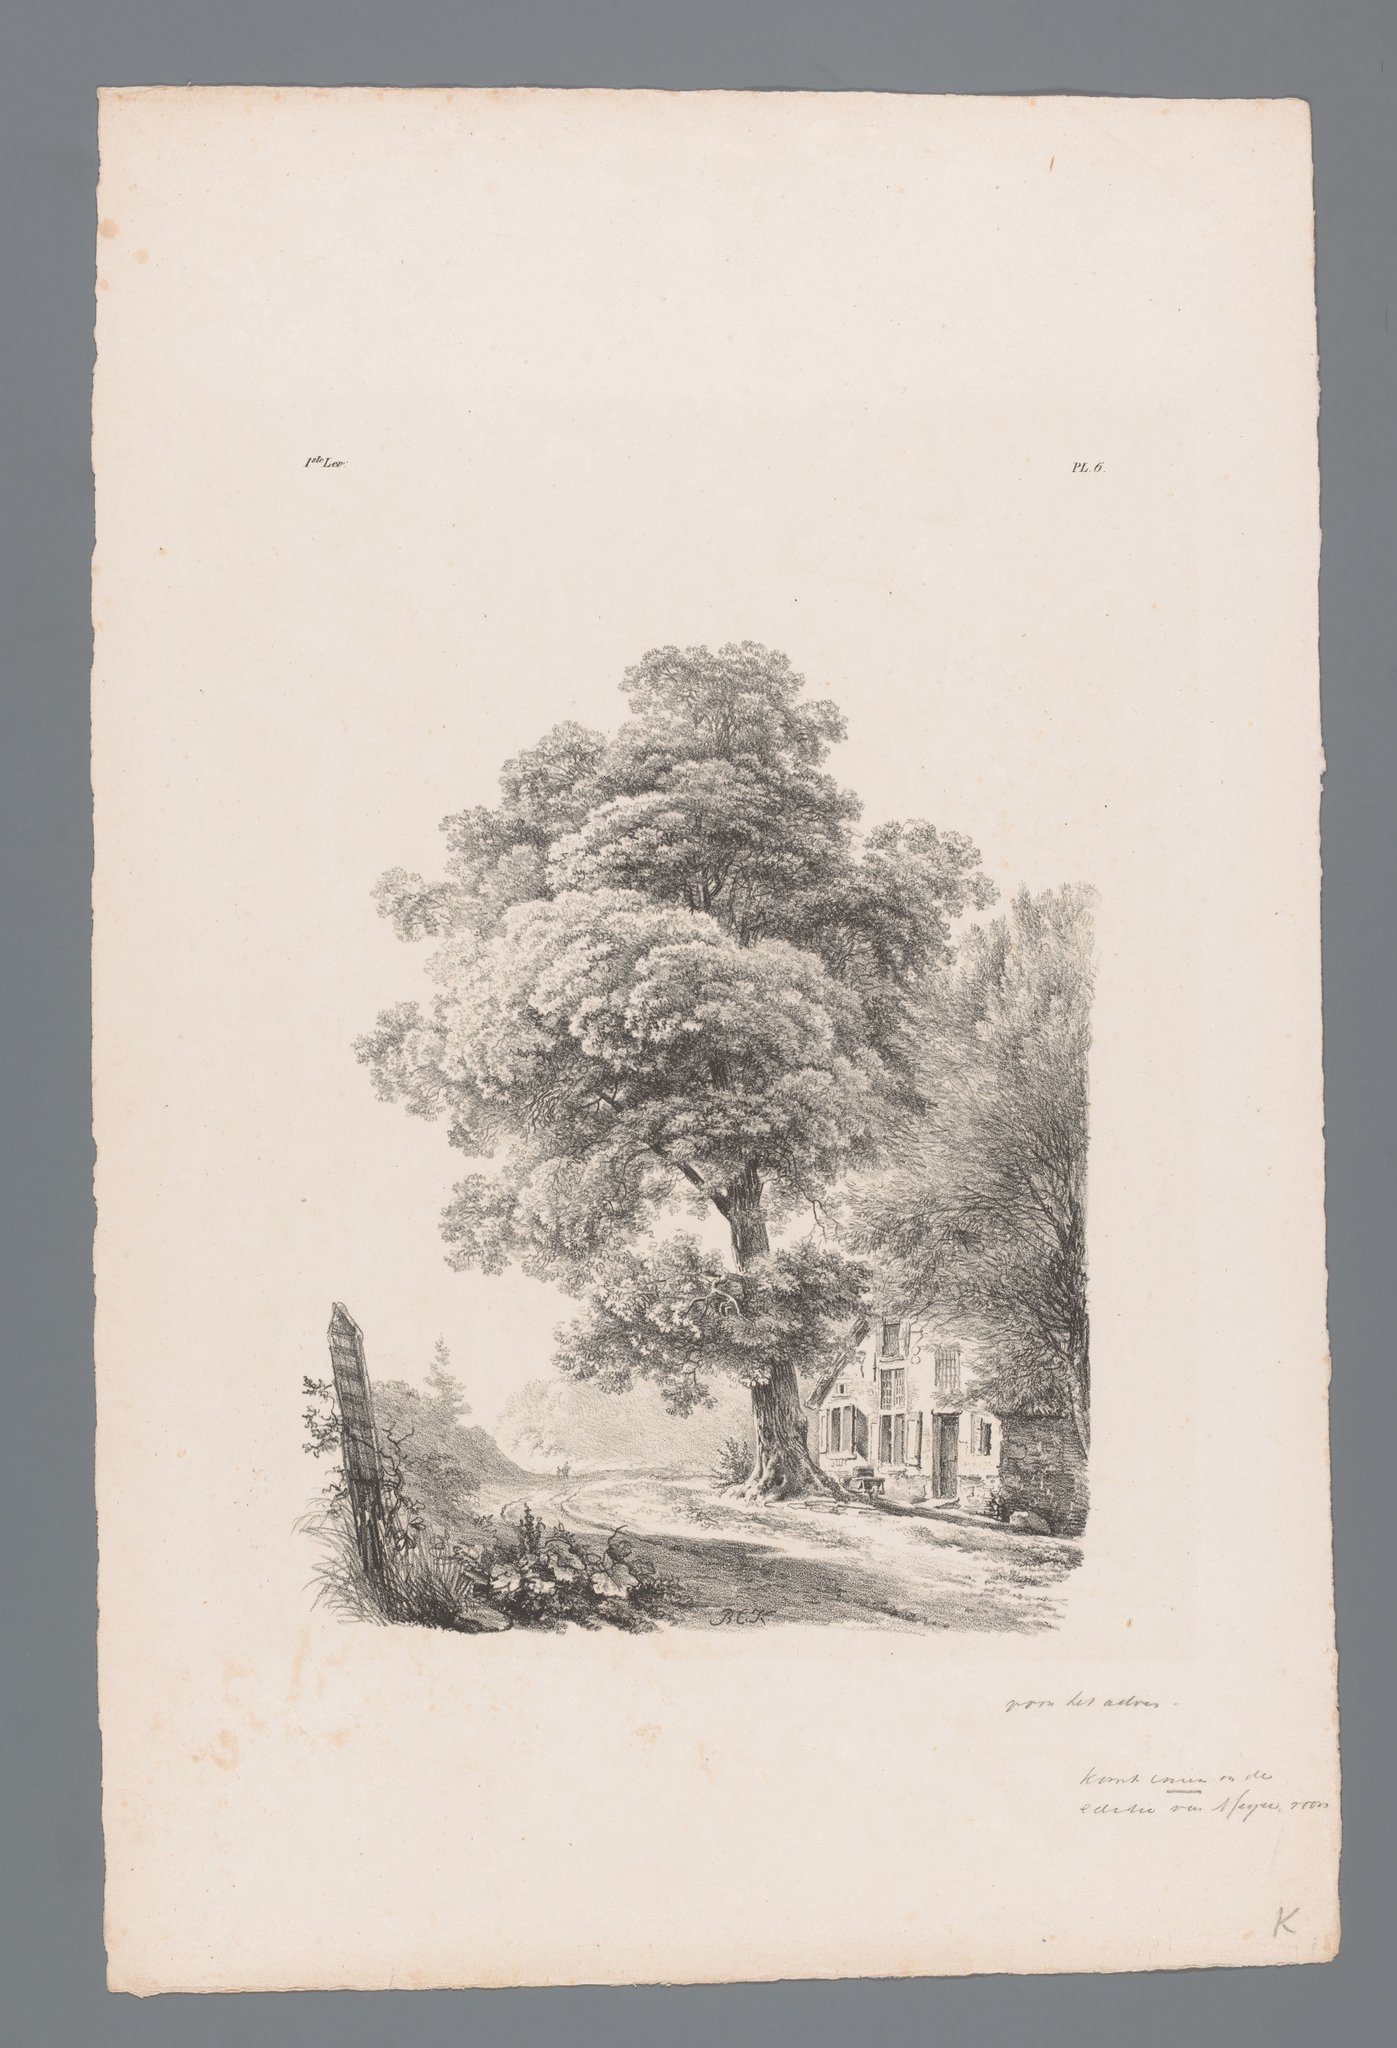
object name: print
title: Landschap studiën eerste levering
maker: barend cornelis koekkoek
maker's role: draughtsman, painter, print maker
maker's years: 1803-1862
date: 1829-1844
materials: paper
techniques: lithograph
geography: amsterdam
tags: trees, road, path, farm (building)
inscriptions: inscription: ‘Voor het adres / komt niet in de / editie van Meyers voor’, collector's mark: Lugt 2228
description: In 1829 en 1830 gaf Koekkoek, samen met Daiwaille, zes cahiers uit met ieder zes prenten getiteld Landschapstudiën. Deze werden gebruikt in het tekenonderwijs. Vijftien jaar later werd deze reeks, in een andere samenstelling nogmaals uitgegeven door Meyer en Comp in Amsterdam. Zie: De Bruyn Kops, 1963.